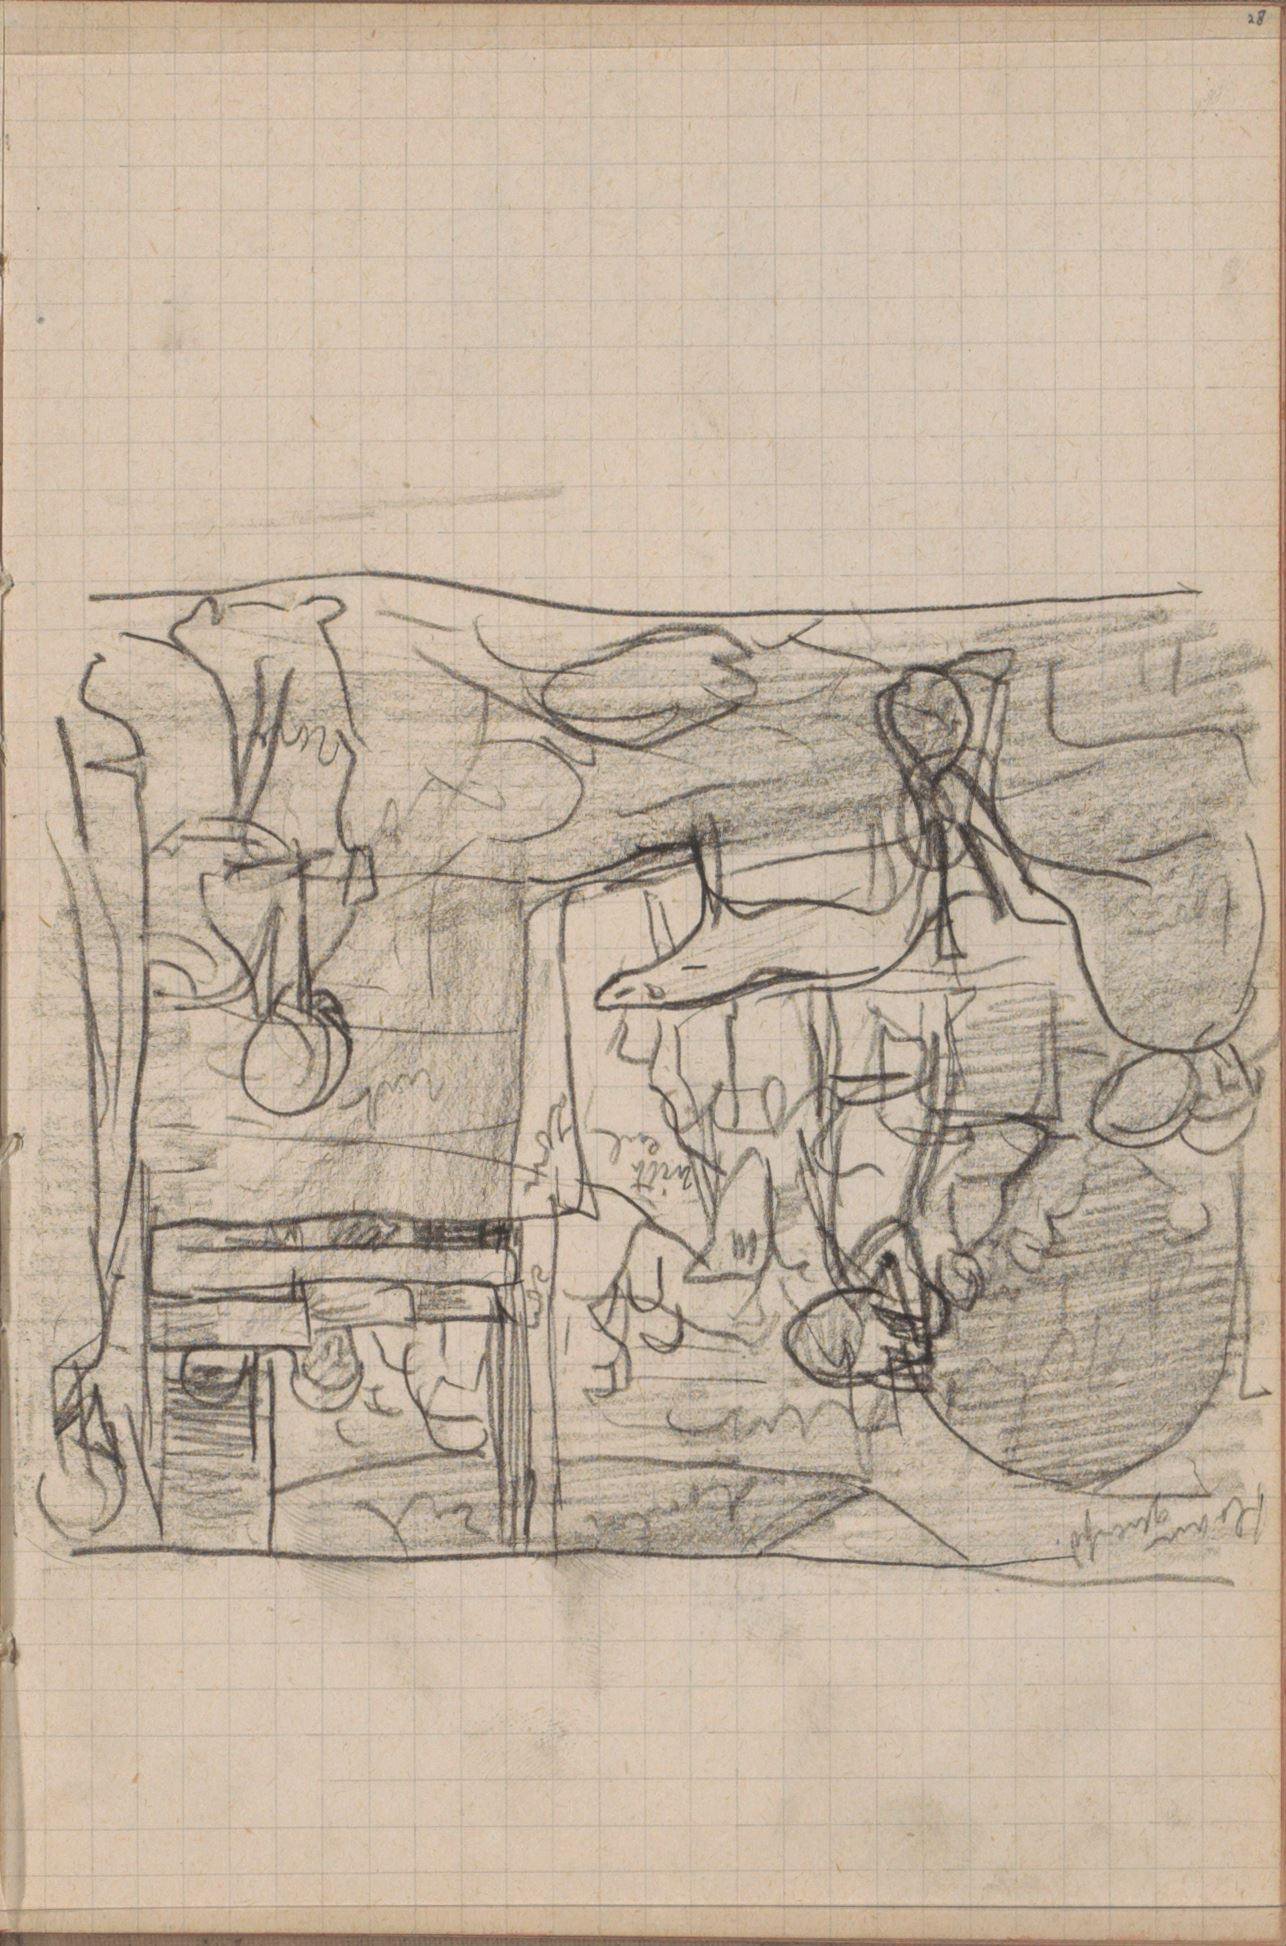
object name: sketchbook leaf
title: Straatscène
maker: marius bauer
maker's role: draughtsman, print maker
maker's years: 1867-1932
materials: chalk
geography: istanbul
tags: arch, archivolt ~ architecture, street (+ city(-scape) with figures, staffage)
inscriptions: kleurnotitie, handgeschreven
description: Met figuren bij een poort en een dier, vermoedelijk een lam. Pagina 28 uit een schetsboek met 51 bladen.